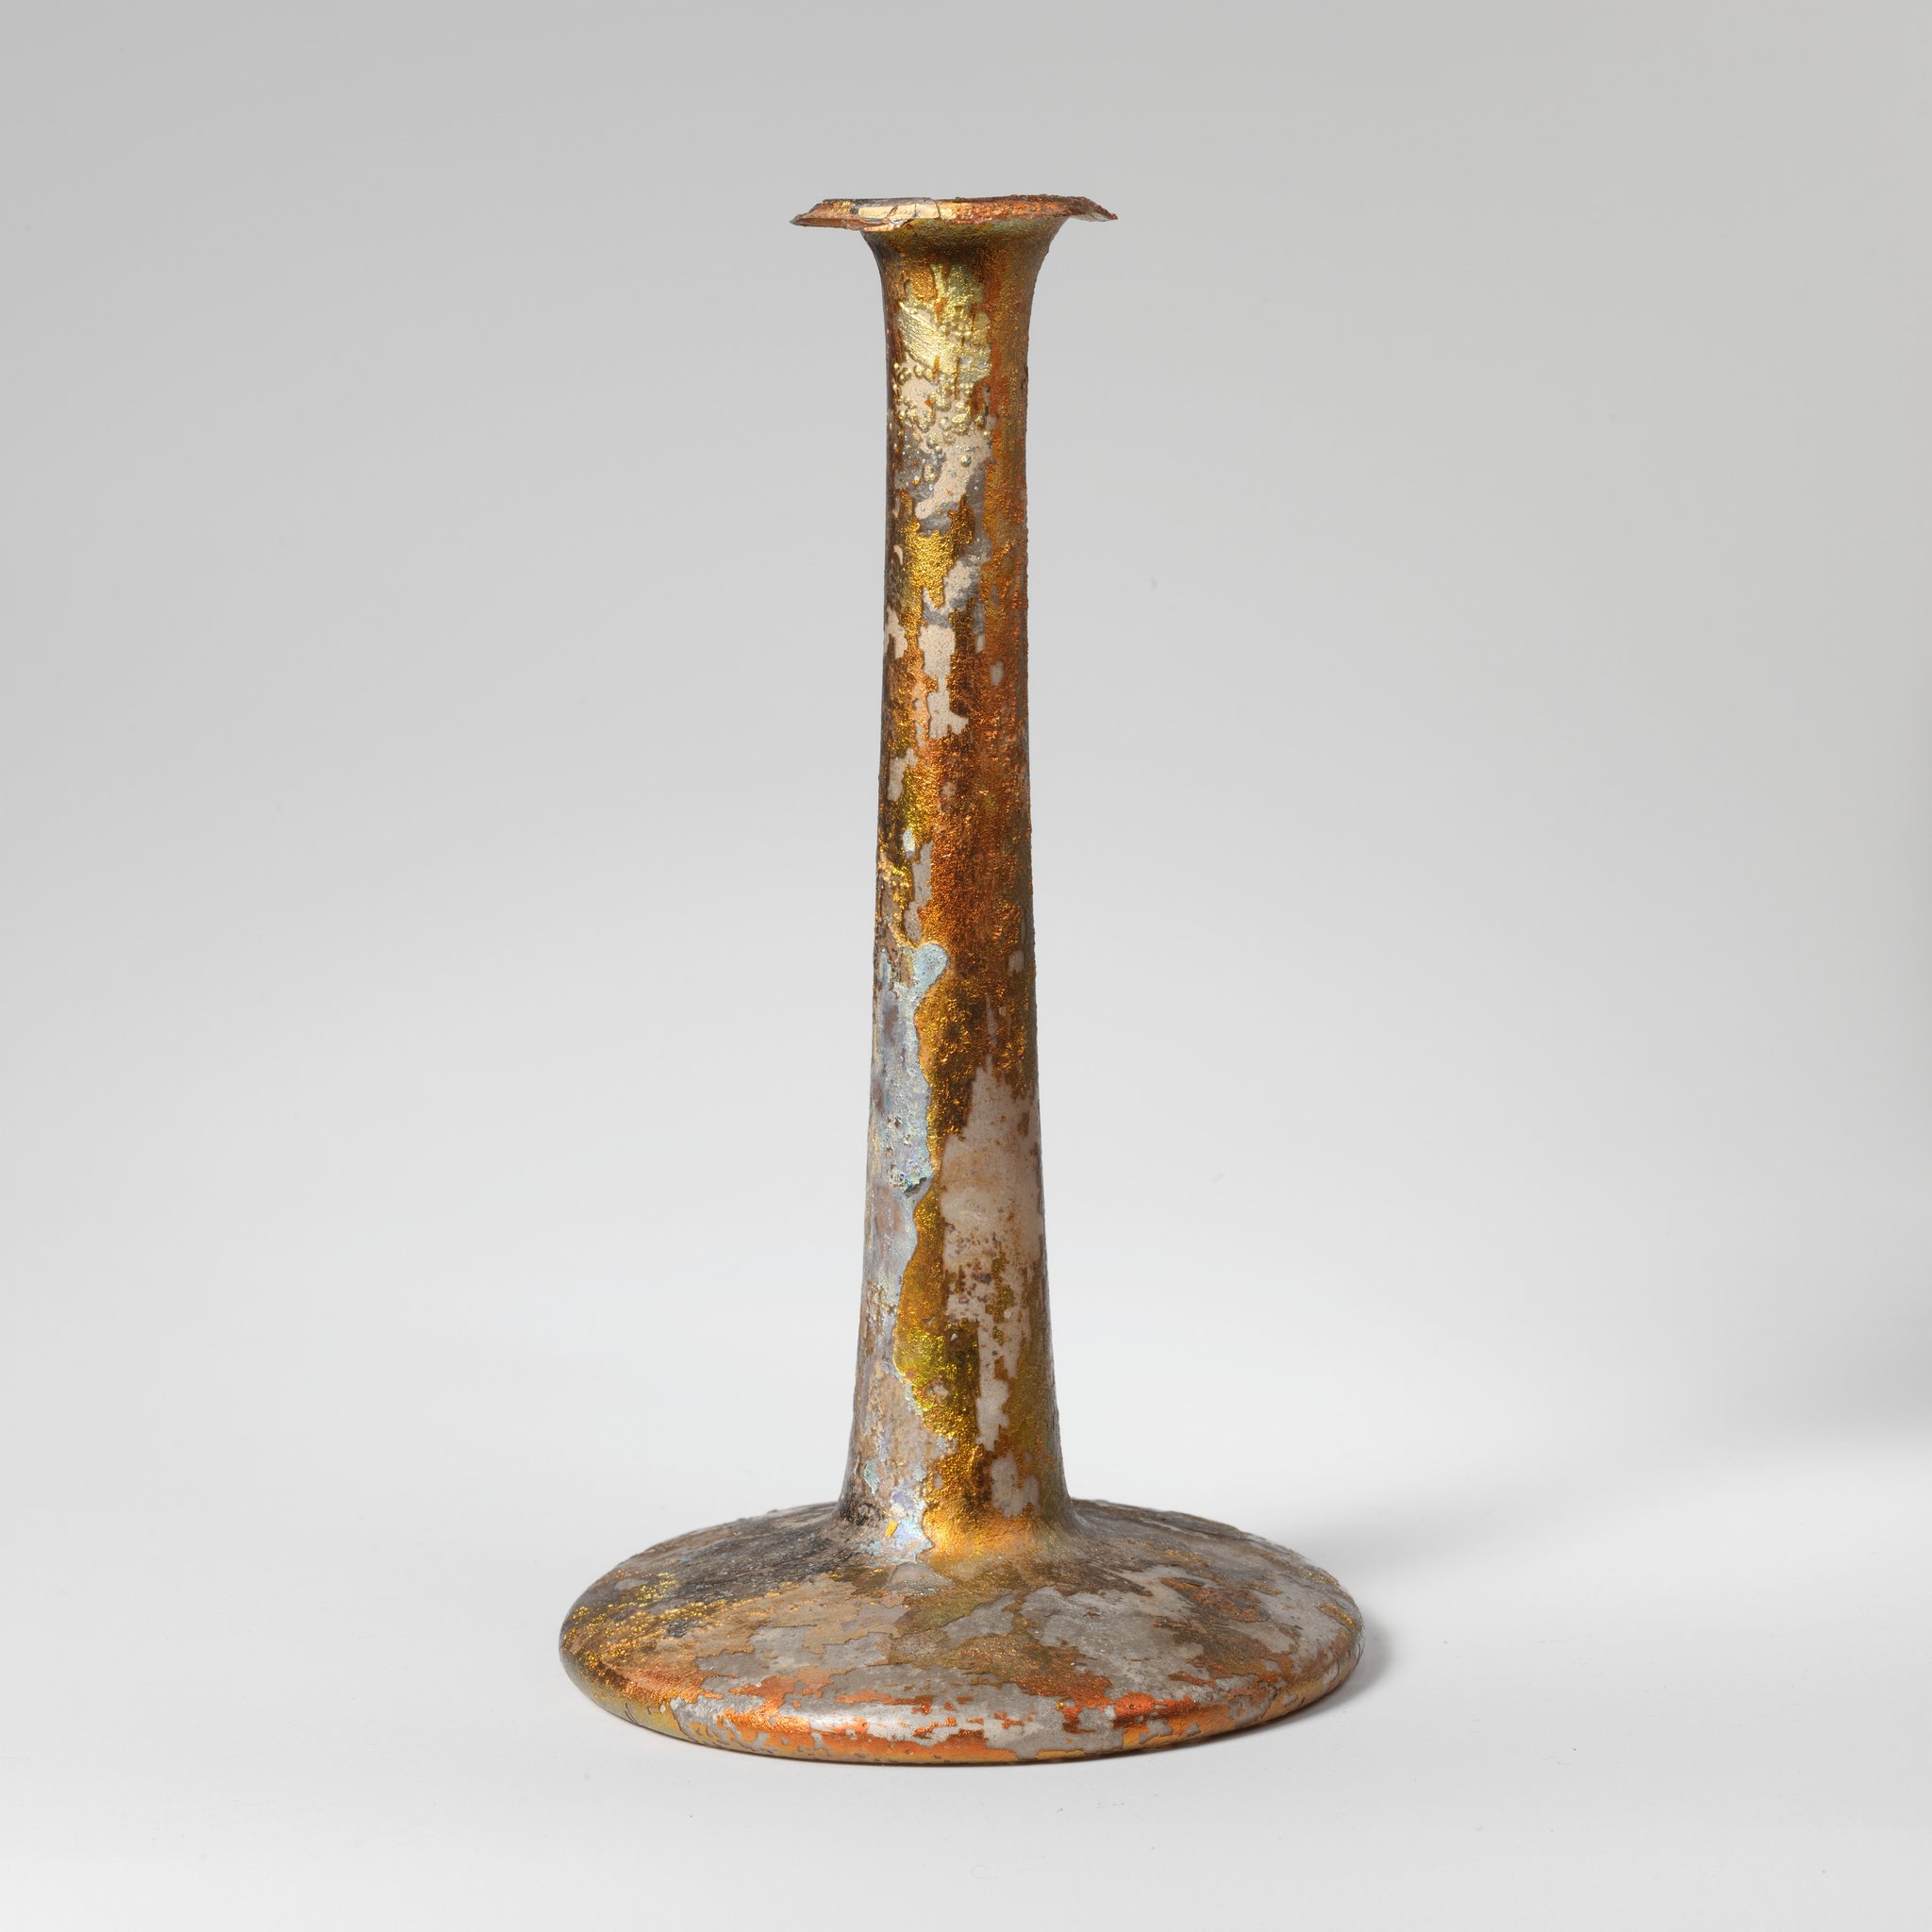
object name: candlestick perfume bottle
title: Glass perfume bottle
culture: roman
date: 101-300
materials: glass